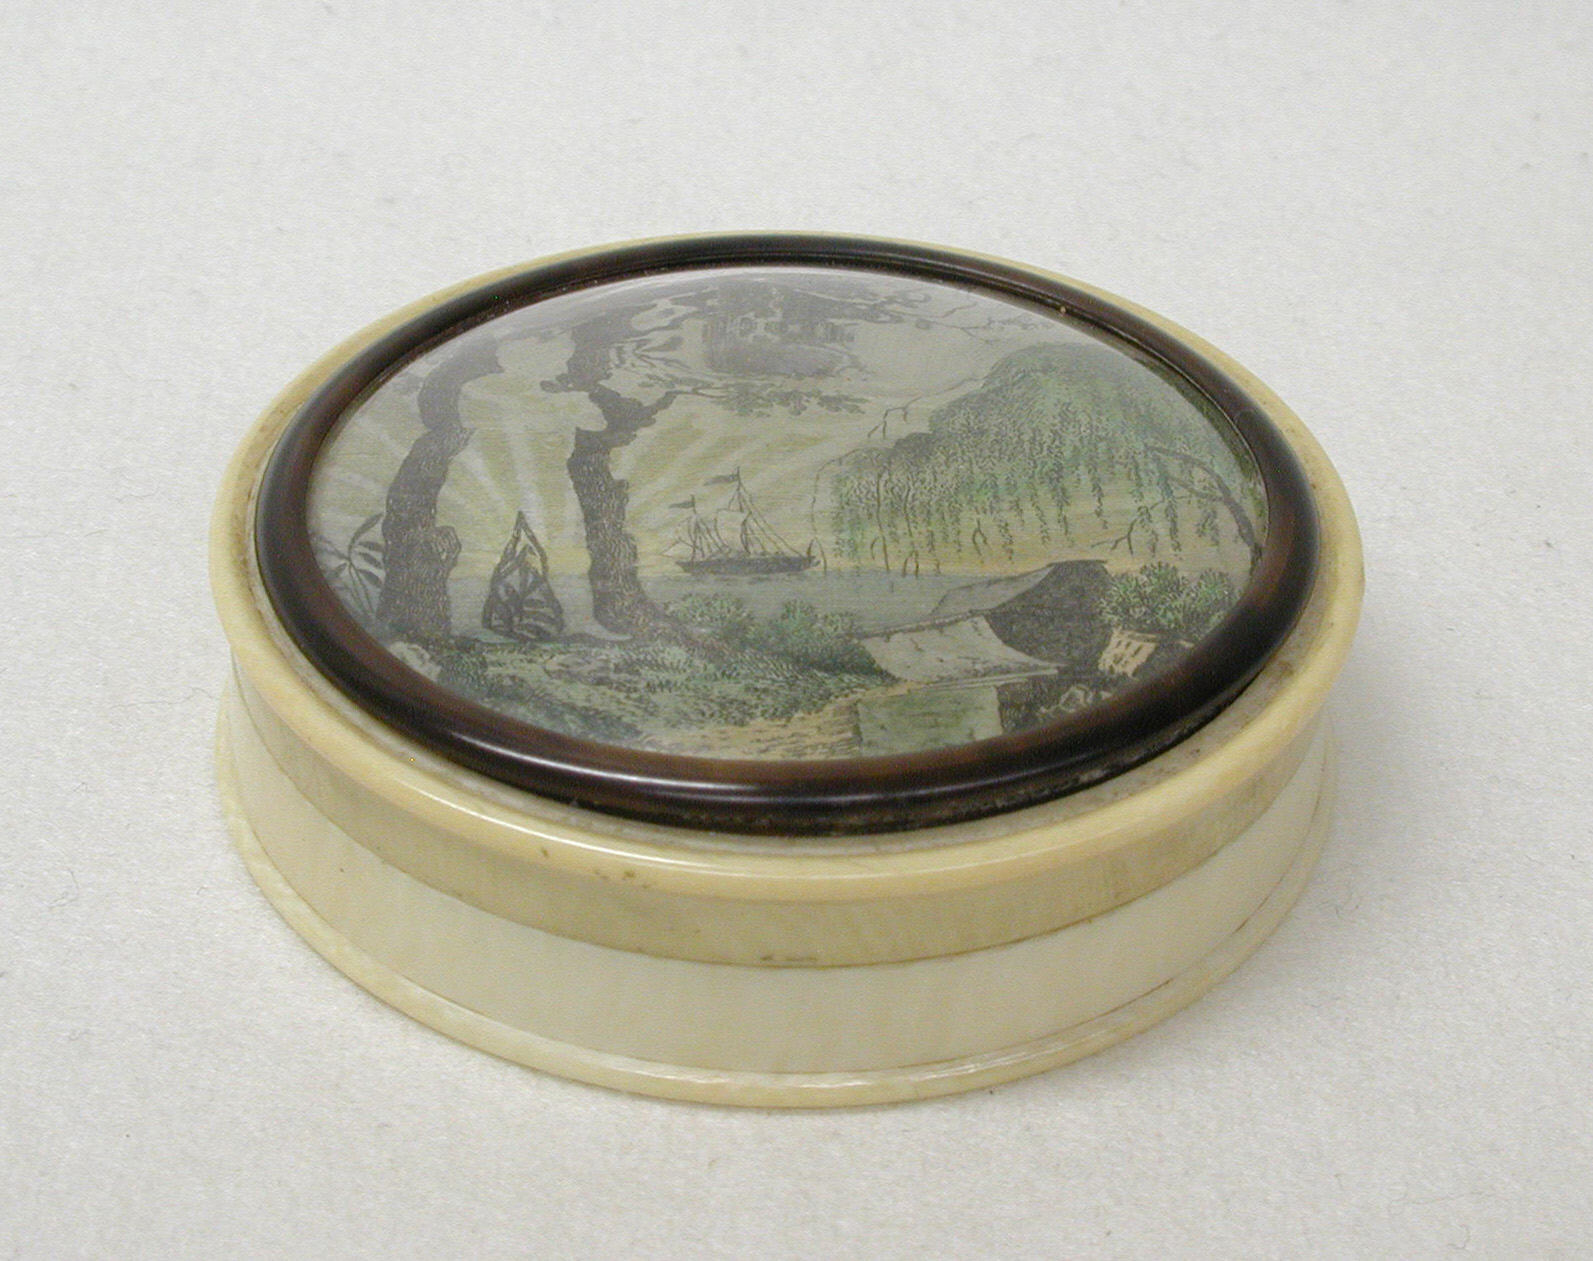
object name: box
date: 1820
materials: glass, ivory, paper, shell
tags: landscapes,boats